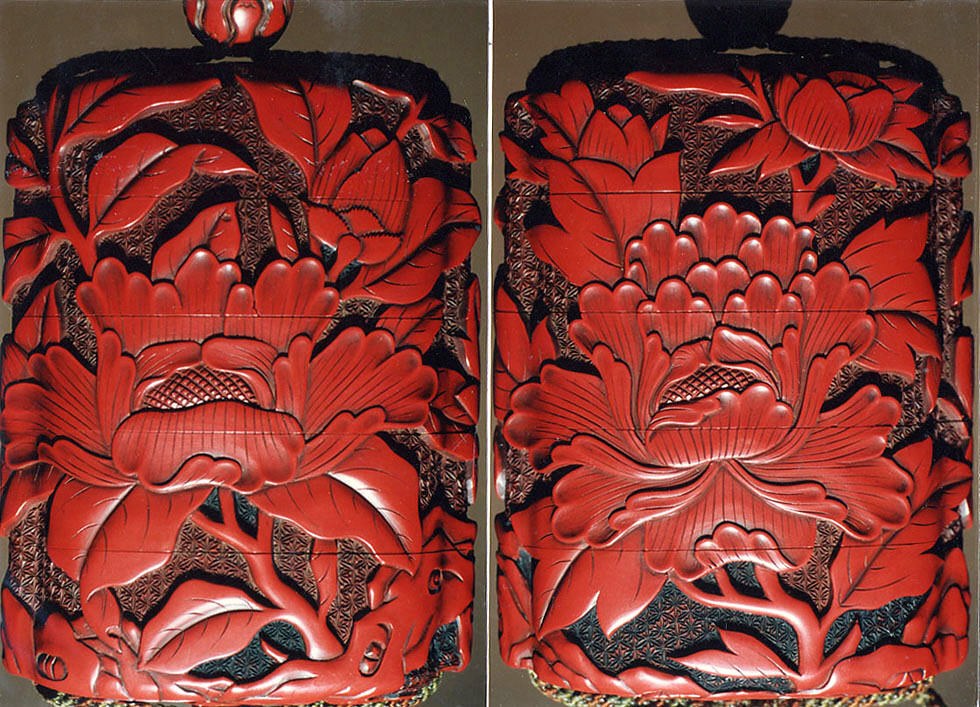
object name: inrō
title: Case (Inrō) with Design of Large Flowering Peony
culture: japanese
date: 1701-1900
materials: lacquer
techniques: carving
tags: peonies